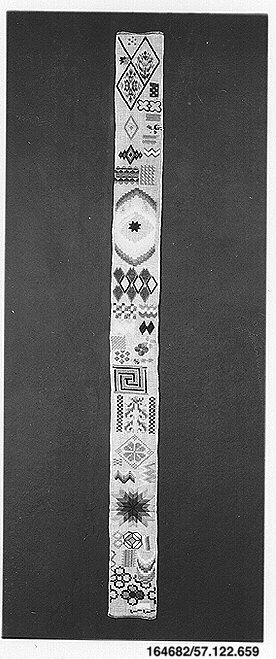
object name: sampler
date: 1801-1900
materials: canvas, wool